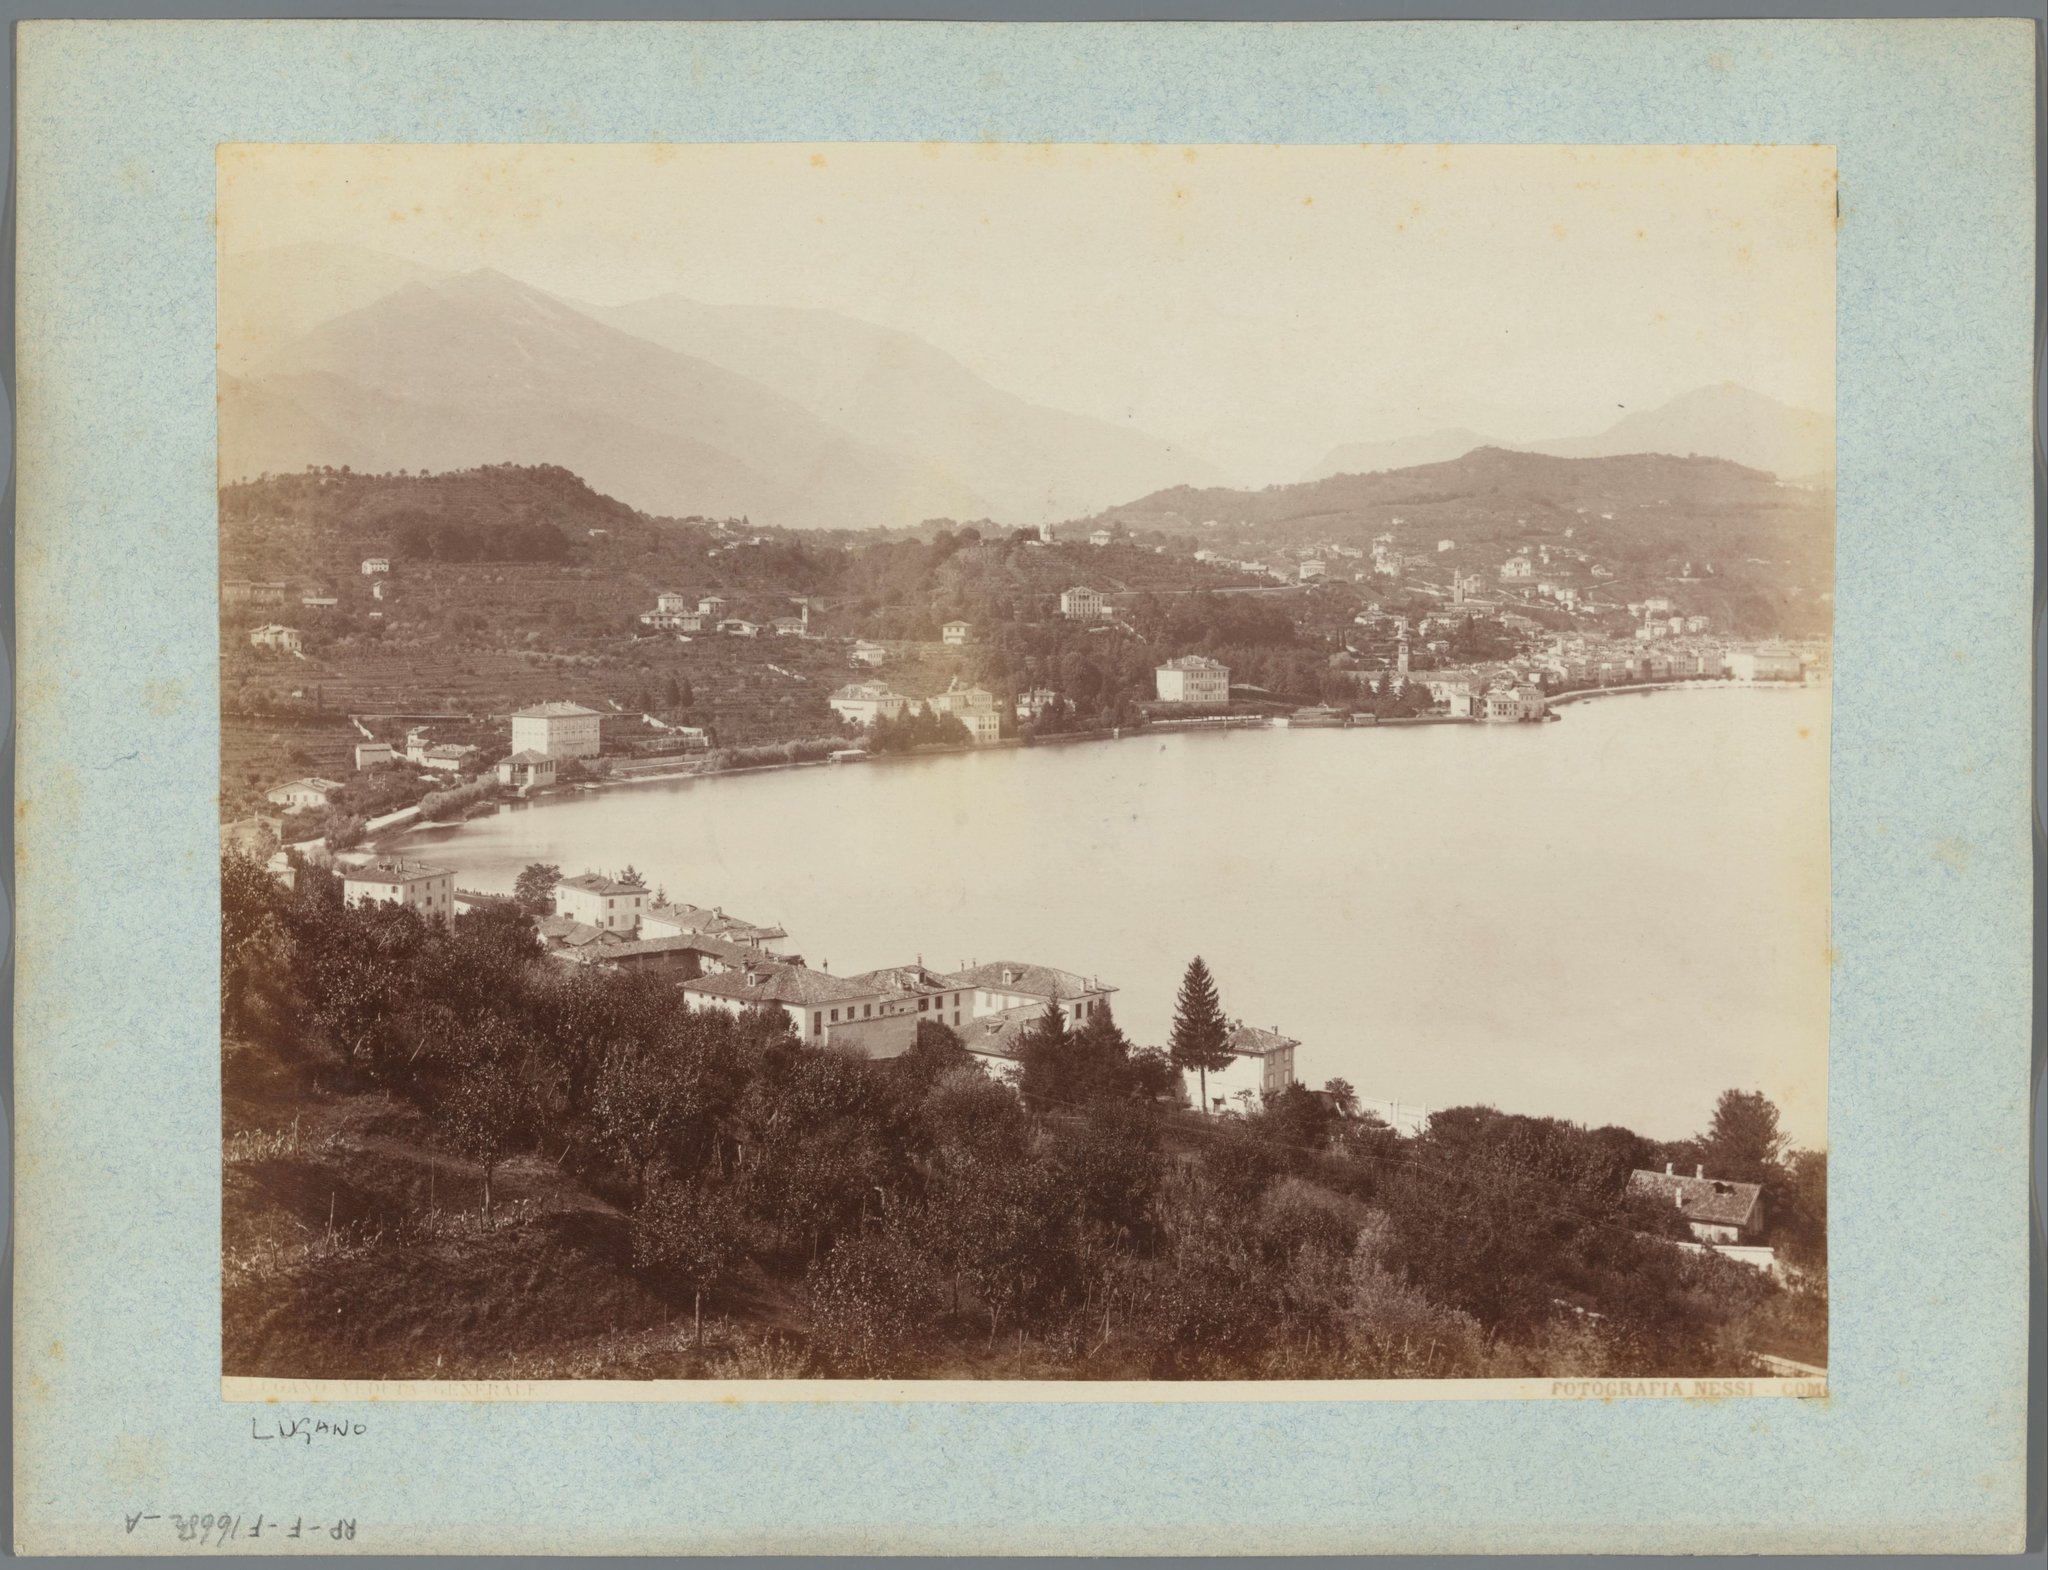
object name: photograph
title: Gezicht op Lugano aan het Comomeer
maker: antonio nessi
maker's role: fotograaf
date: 1851-1900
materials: cardboard, paper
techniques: albumen print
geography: lugano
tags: lake, prospect of city, town panorama, silhouette of city, mountains